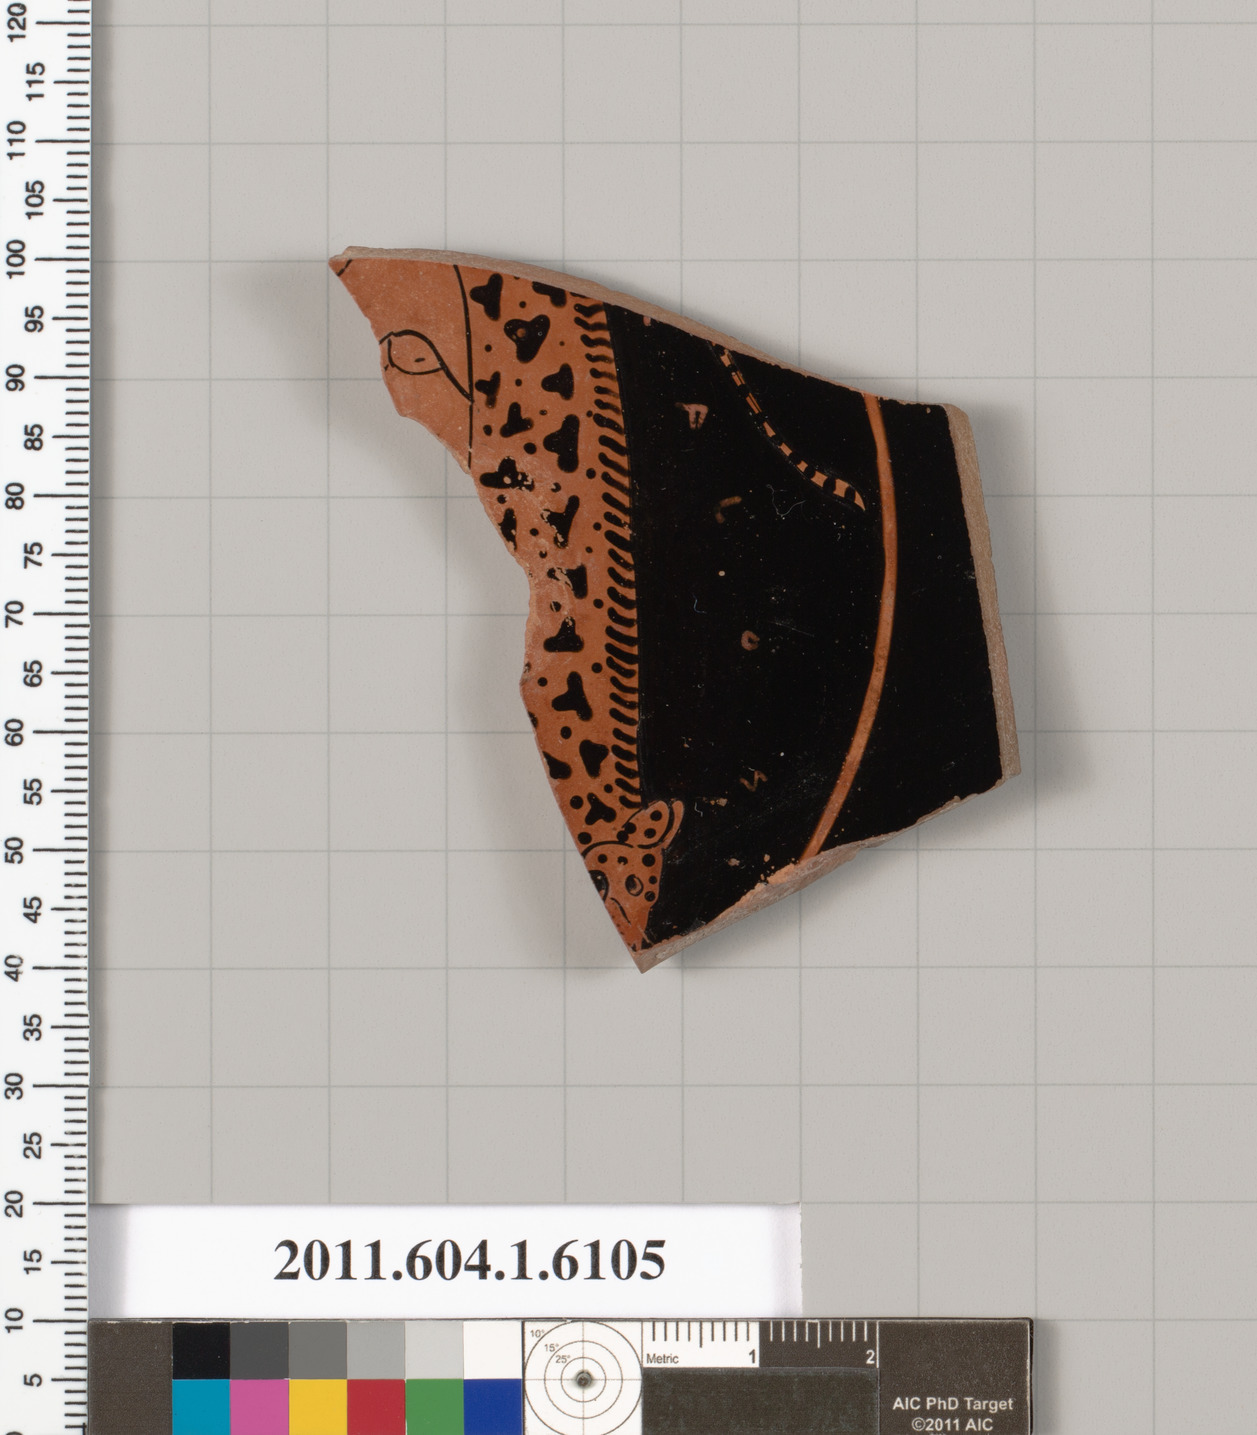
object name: kylix fragment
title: Terracotta fragment of a kylix (drinking cup)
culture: greek, attic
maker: apollodoros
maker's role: artist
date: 500-490 BCE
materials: terracotta